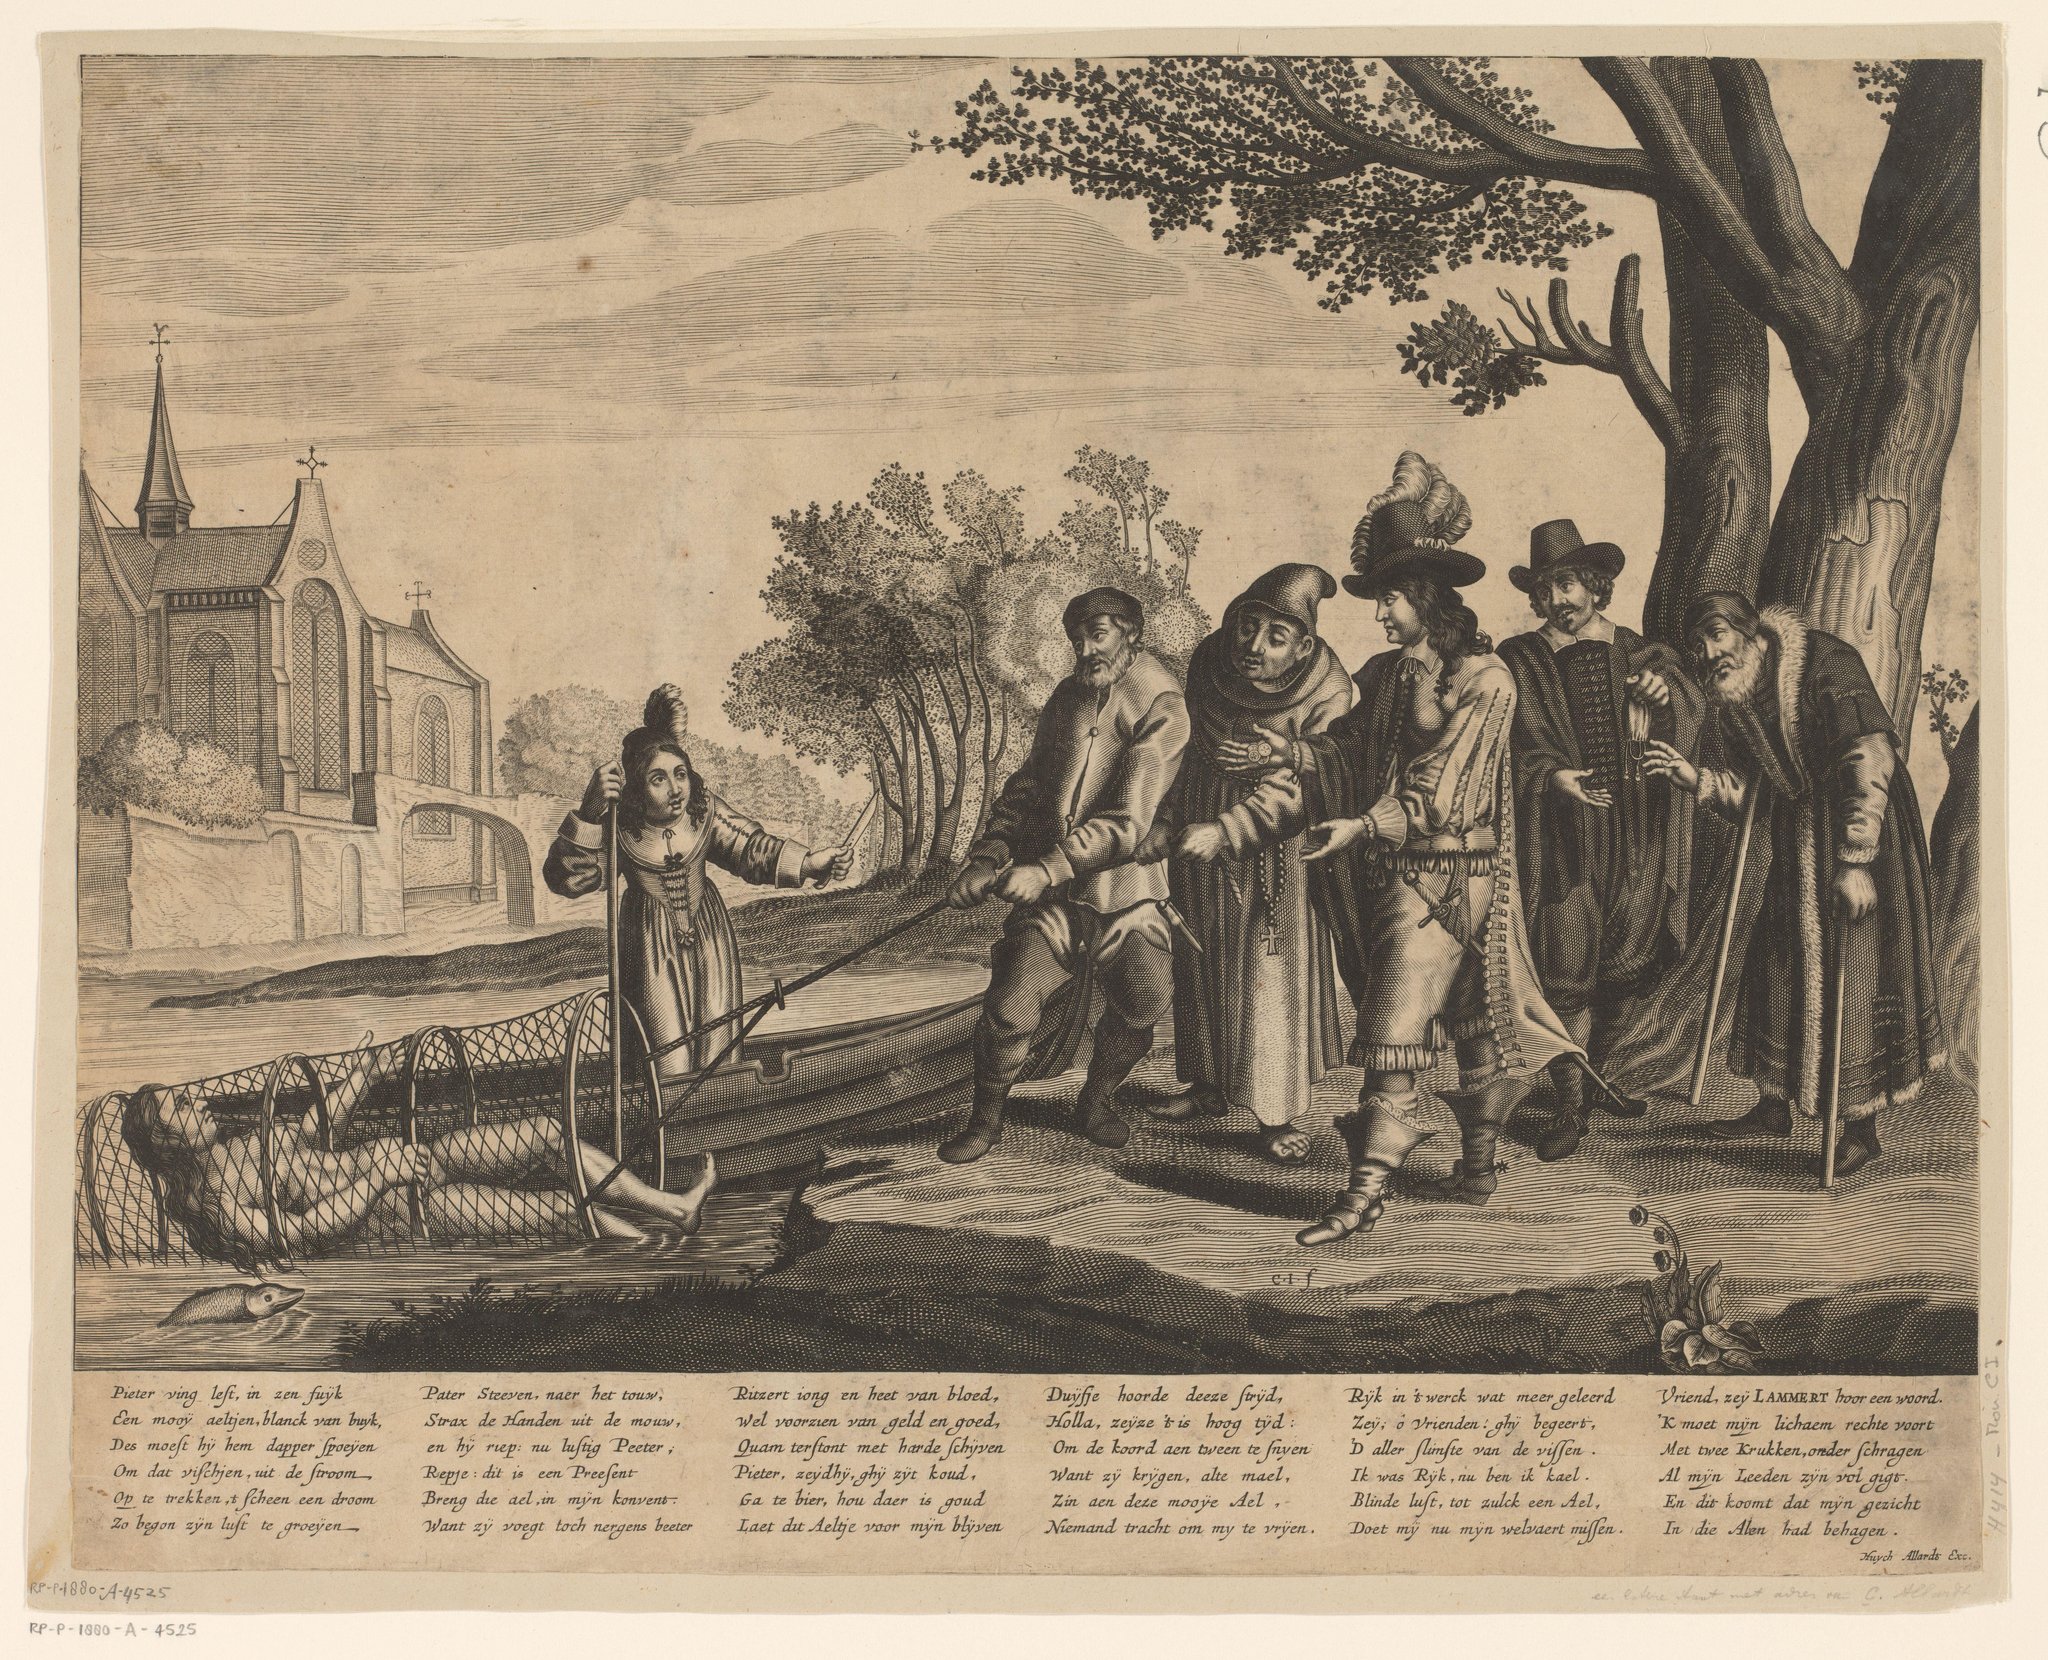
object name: print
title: Jonge vrouw in een fuik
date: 1645-1684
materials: paper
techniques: engraving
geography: amsterdam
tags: adolescent, young woman, maiden, church (exterior), monk(s), friar(s), fishing (sports)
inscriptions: collector's mark: Lugt 2228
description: Een visser en een monnik trekken een fuik aan land, waarin een jonge vrouw ligt. Een jonge man biedt hun geld voor de 'vangst', terwijl een oude man op krukken en een man met een lege geldbuidel hen waarschuwen. In de boot naast de fuik staat een vrouw met een mes in haar hand. Ze staat op het punt om het touw door te snijden. Linksachter een kerk. Onder de voorstelling een 36-regelig vers in het Nederlands met een toelichting.